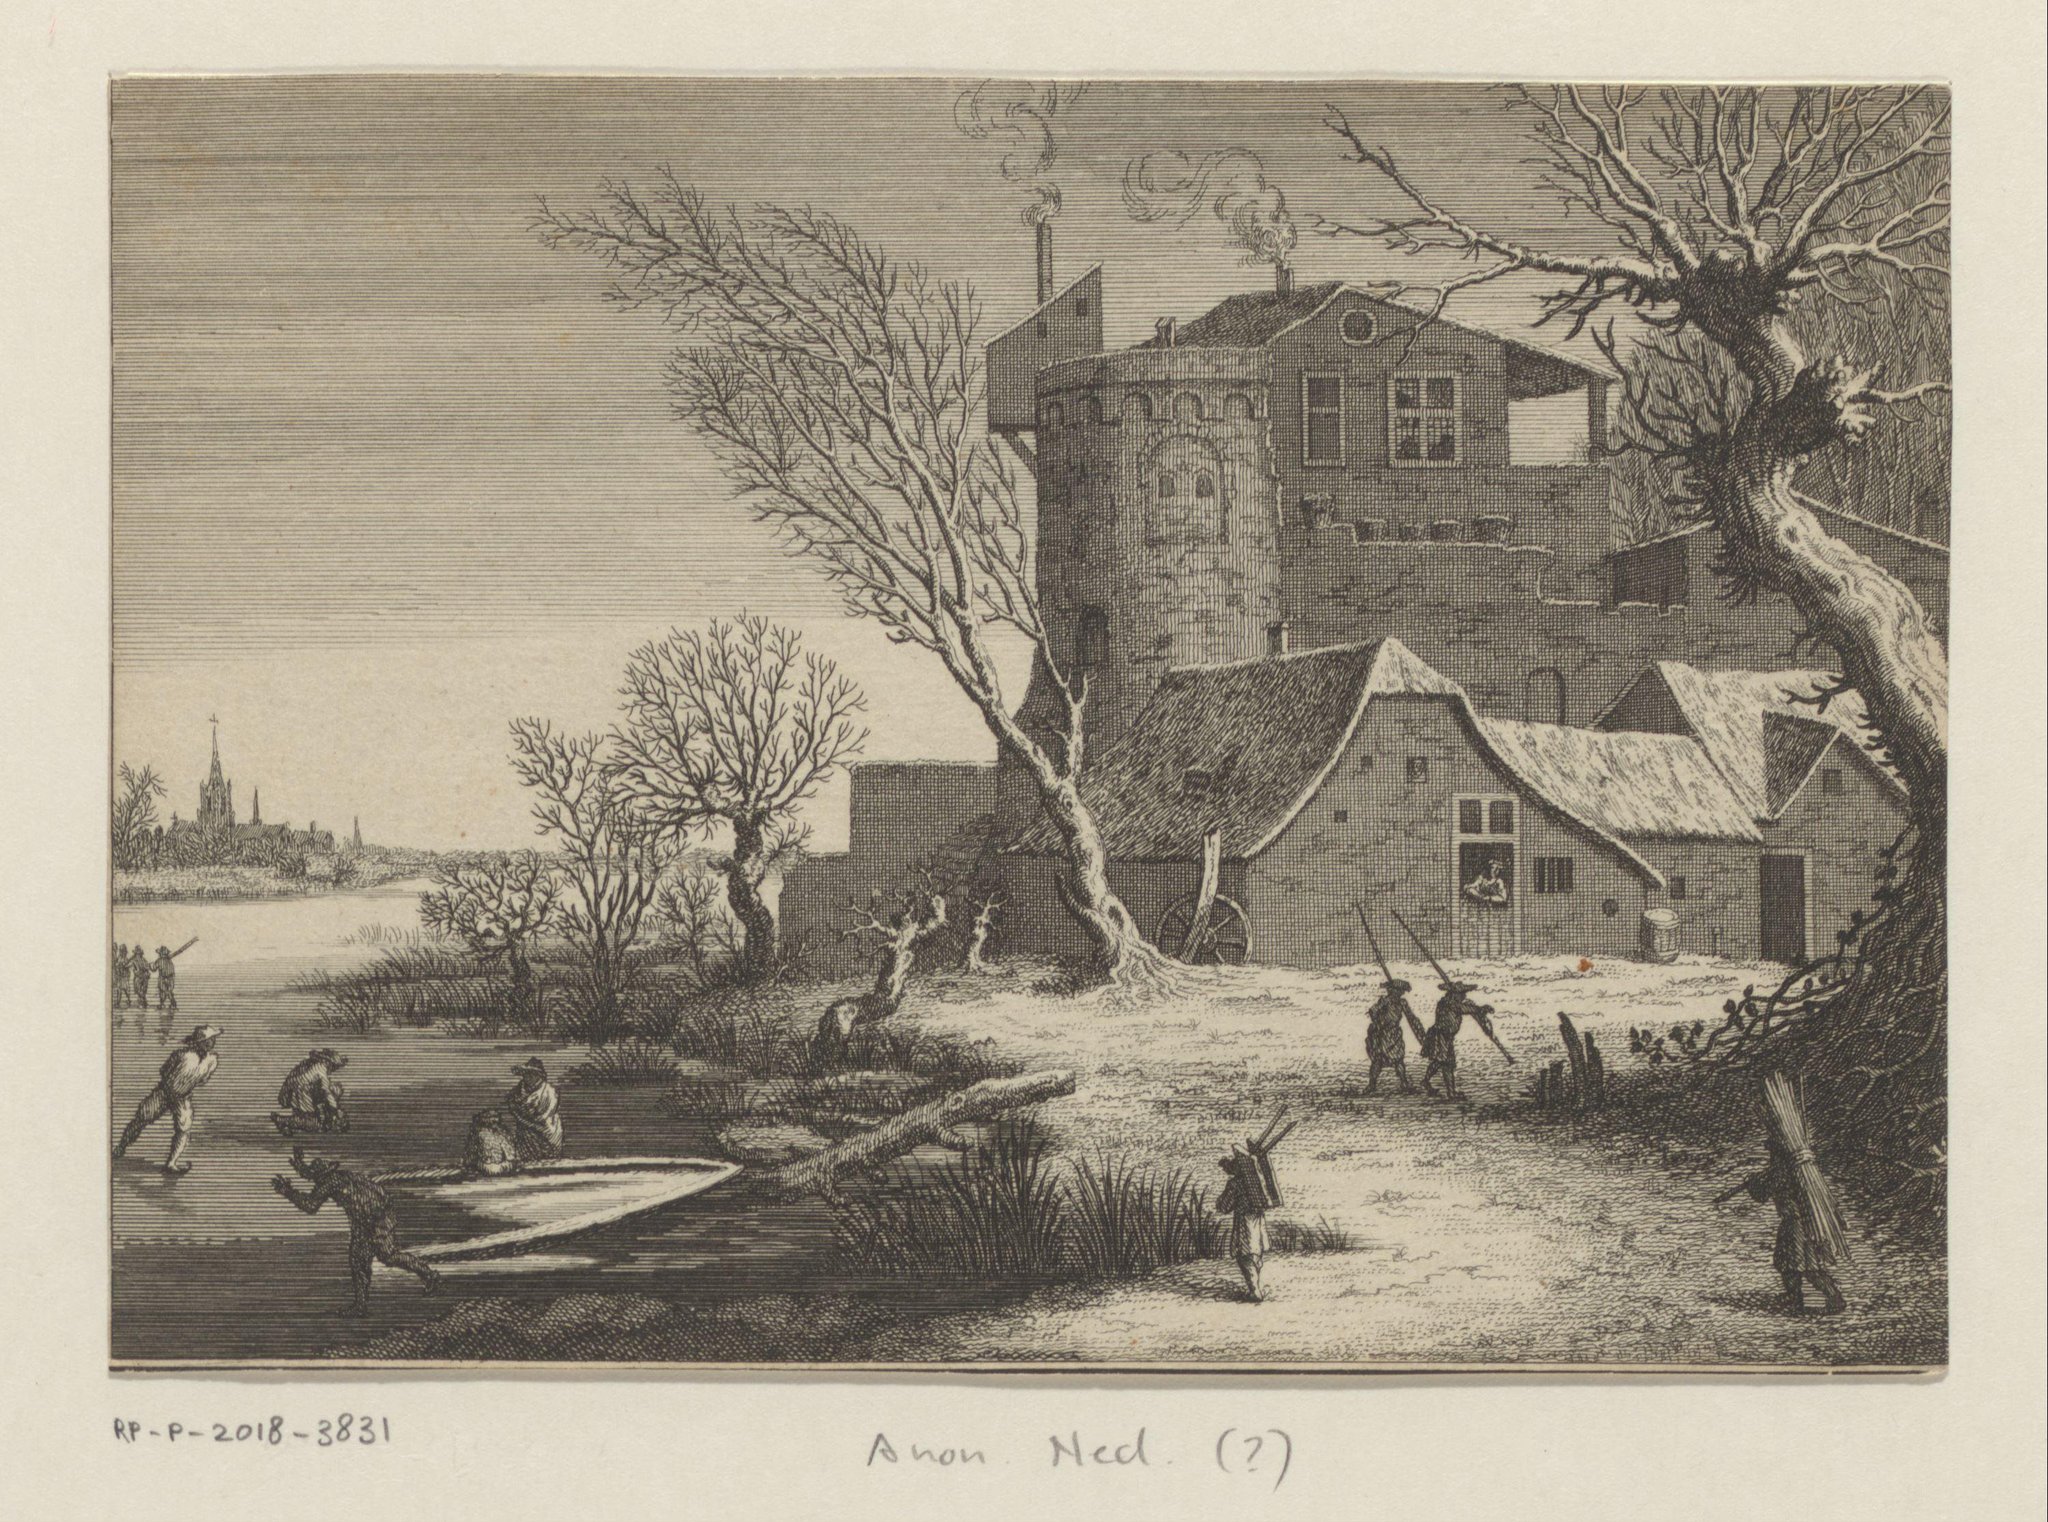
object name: print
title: Wintergezicht op een bouwwerk aan een bevroren rivier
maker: Anonymous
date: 1650-1800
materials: paper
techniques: etching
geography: netherlands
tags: winter landscape; landscape symbolizing winter (the four seasons of the year), skates (winter sports), exterior of industrial structures, factories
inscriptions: collector's mark: Lugt 2228